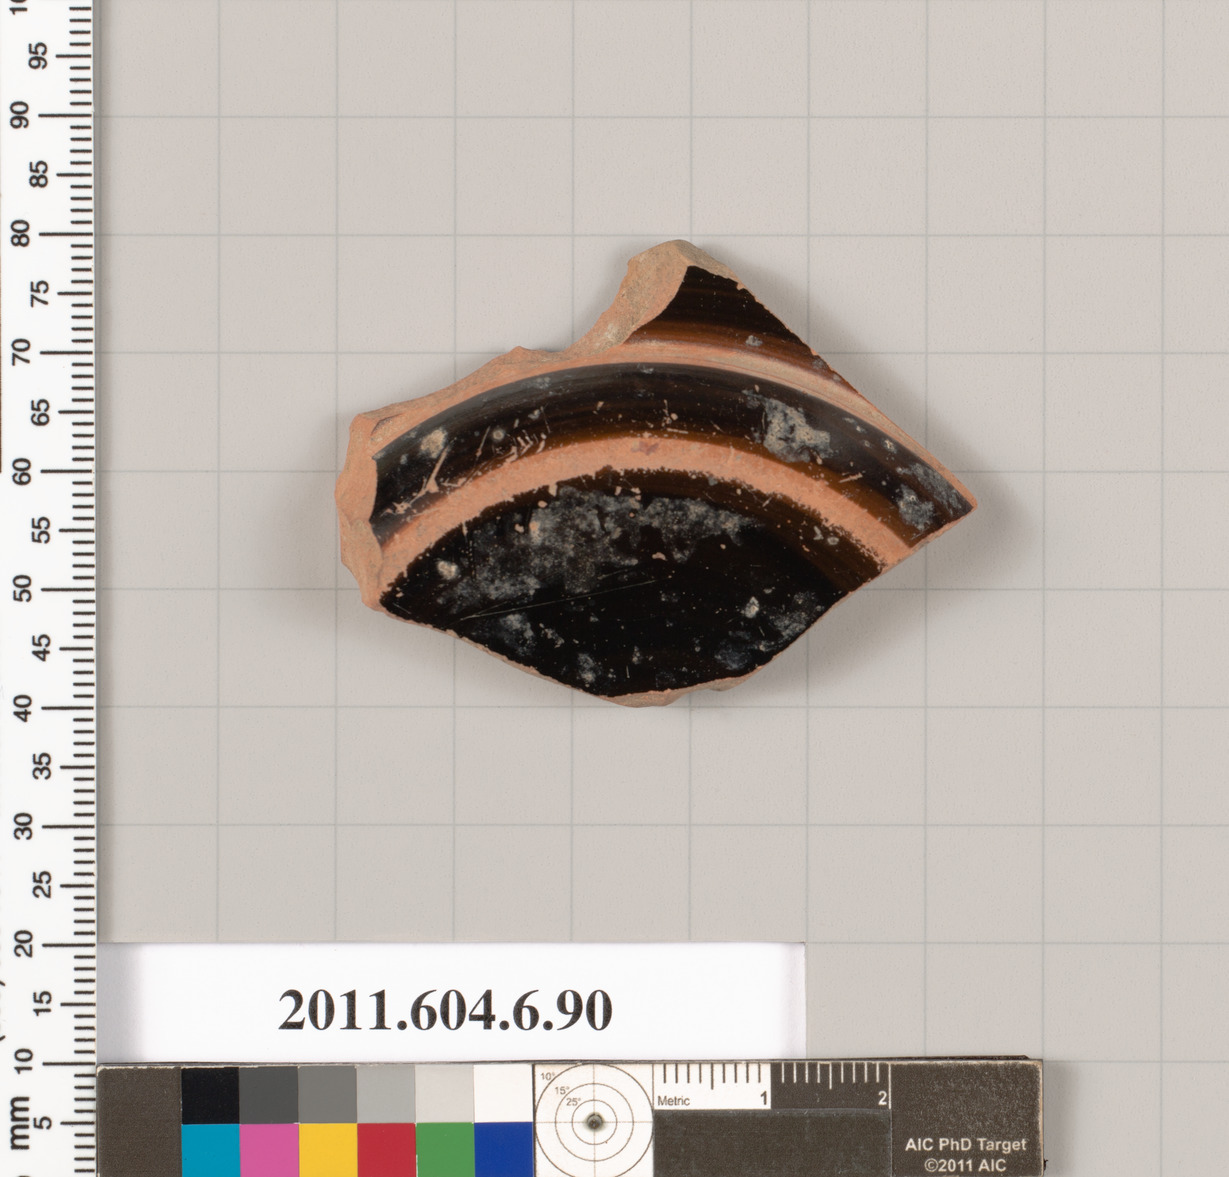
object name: fragment of a dish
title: Terracotta fragment of a dish?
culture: greek, attic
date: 500-401 BCE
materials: terracotta